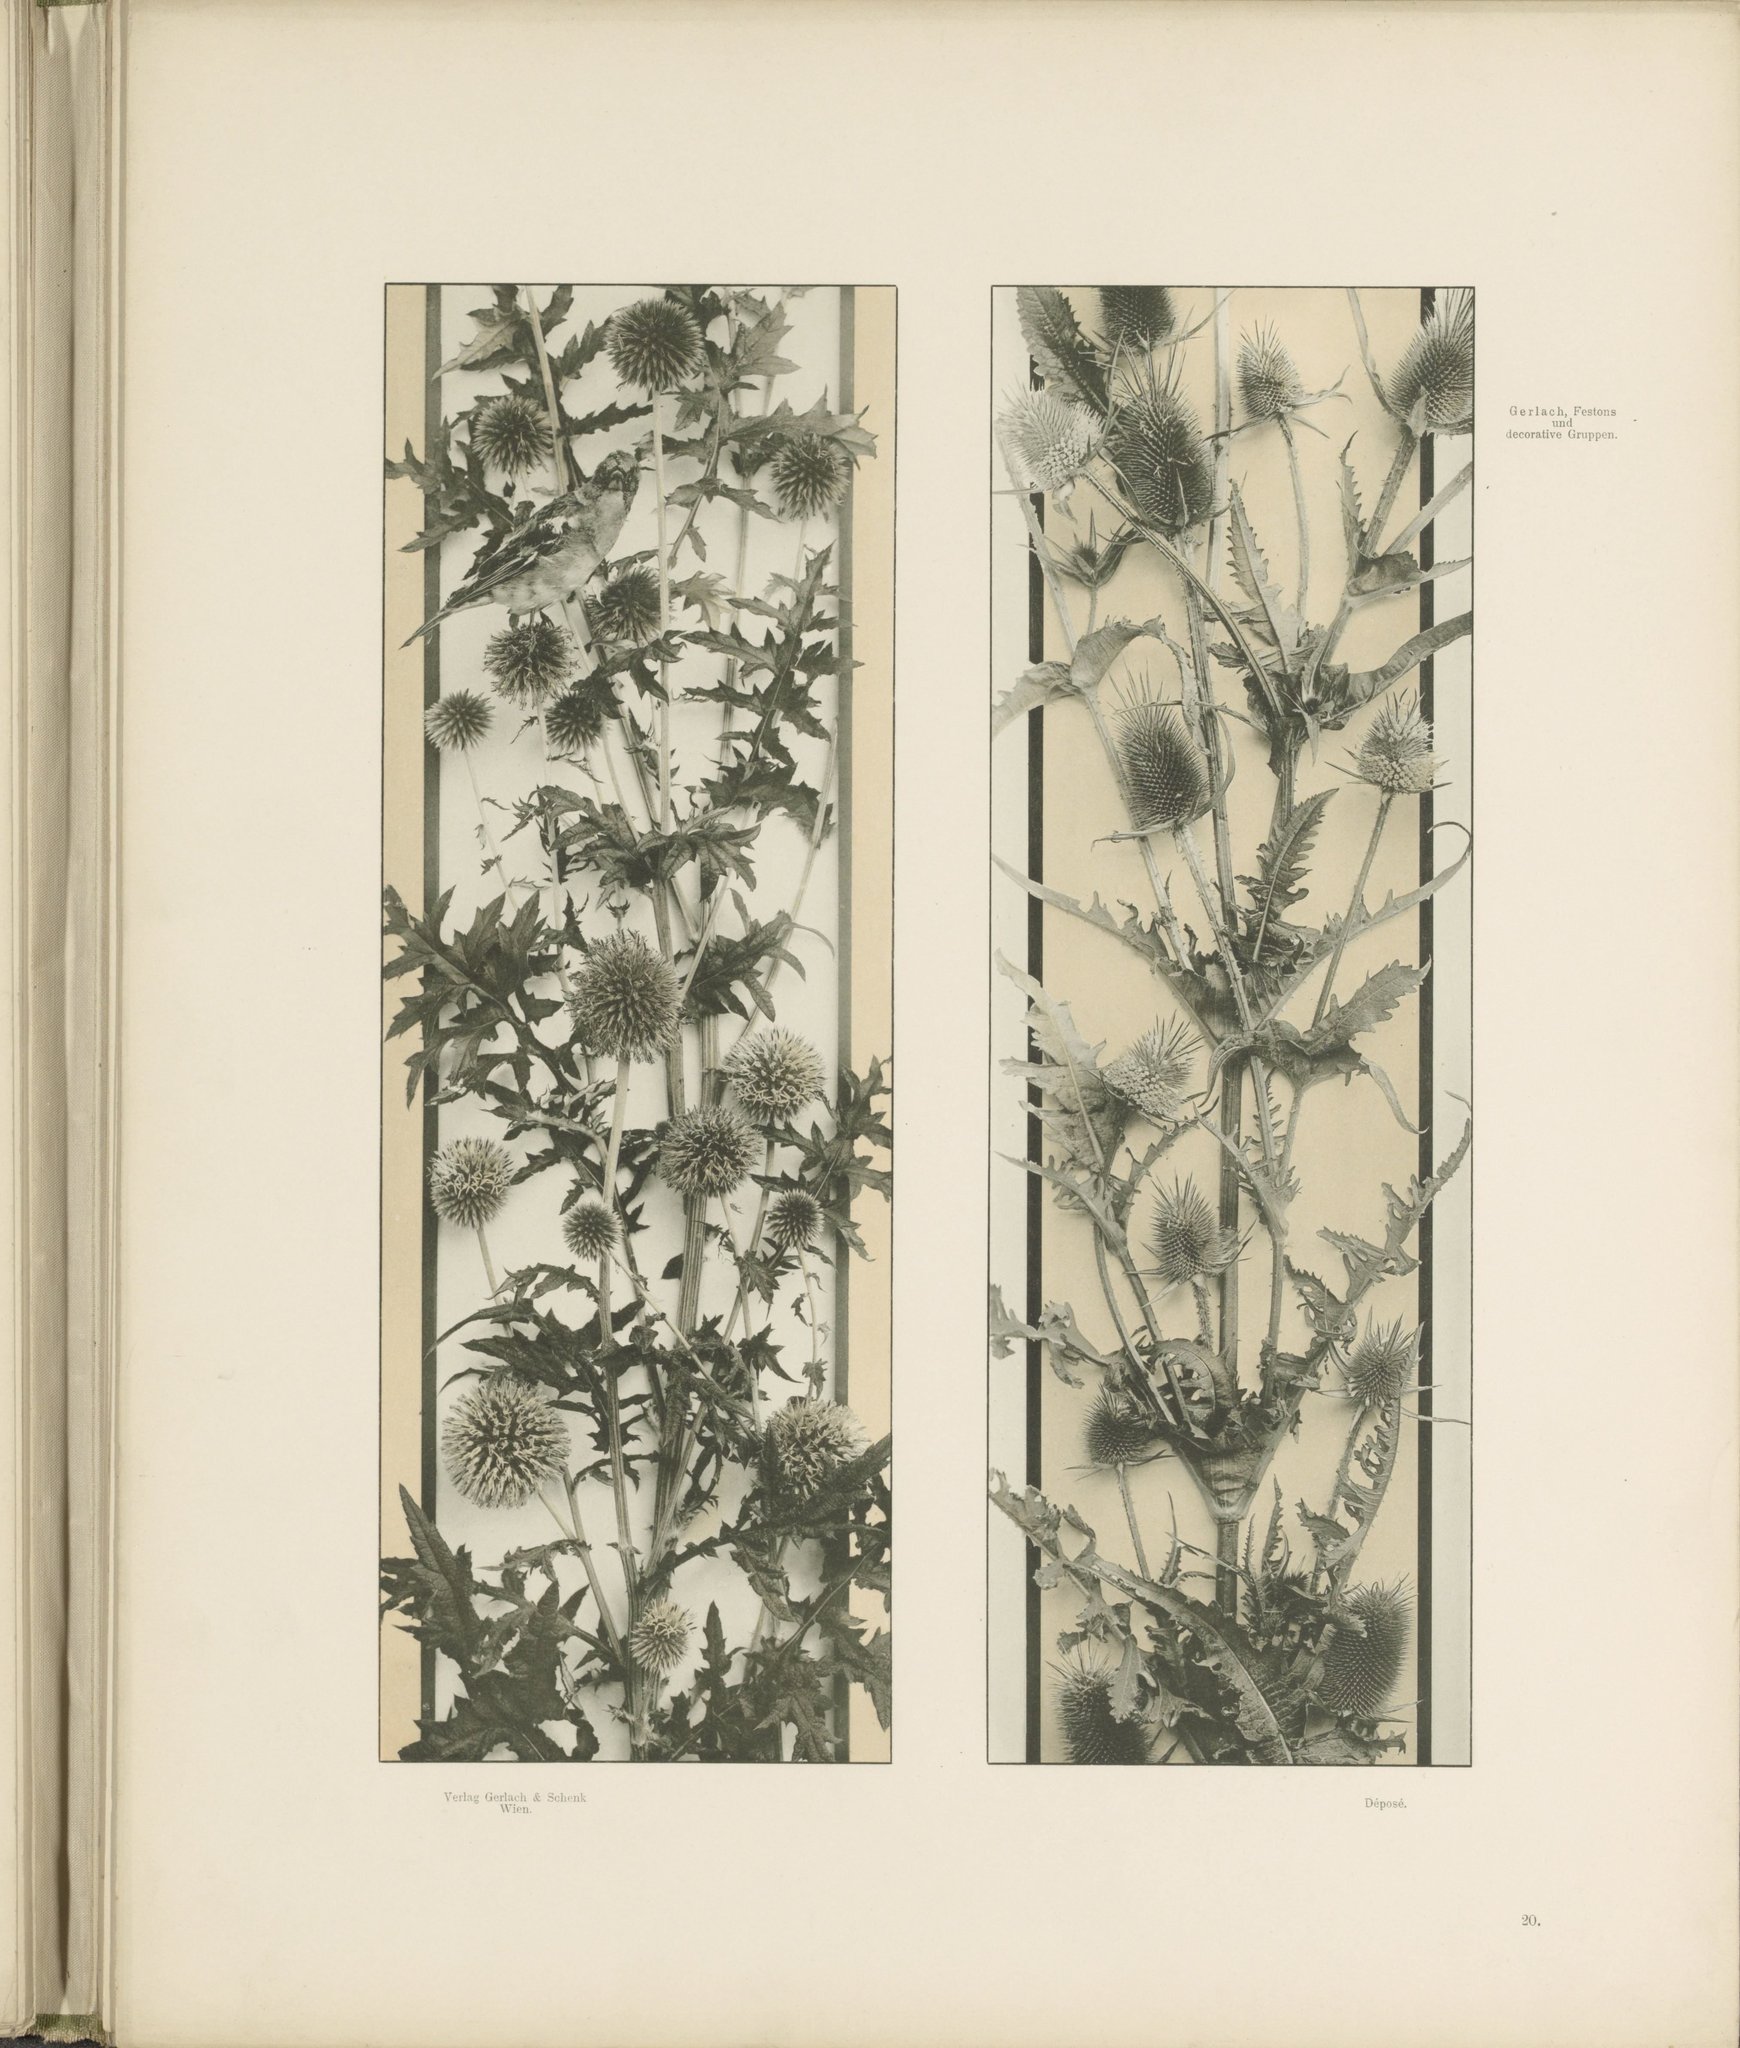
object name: photomechanical print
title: Twee vlakvullingen van kaardebol en kogeldistel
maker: Anonymous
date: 1887-1897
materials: paper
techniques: photograph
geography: vienna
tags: plants and herbs: thistle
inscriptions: number: ‘20.’